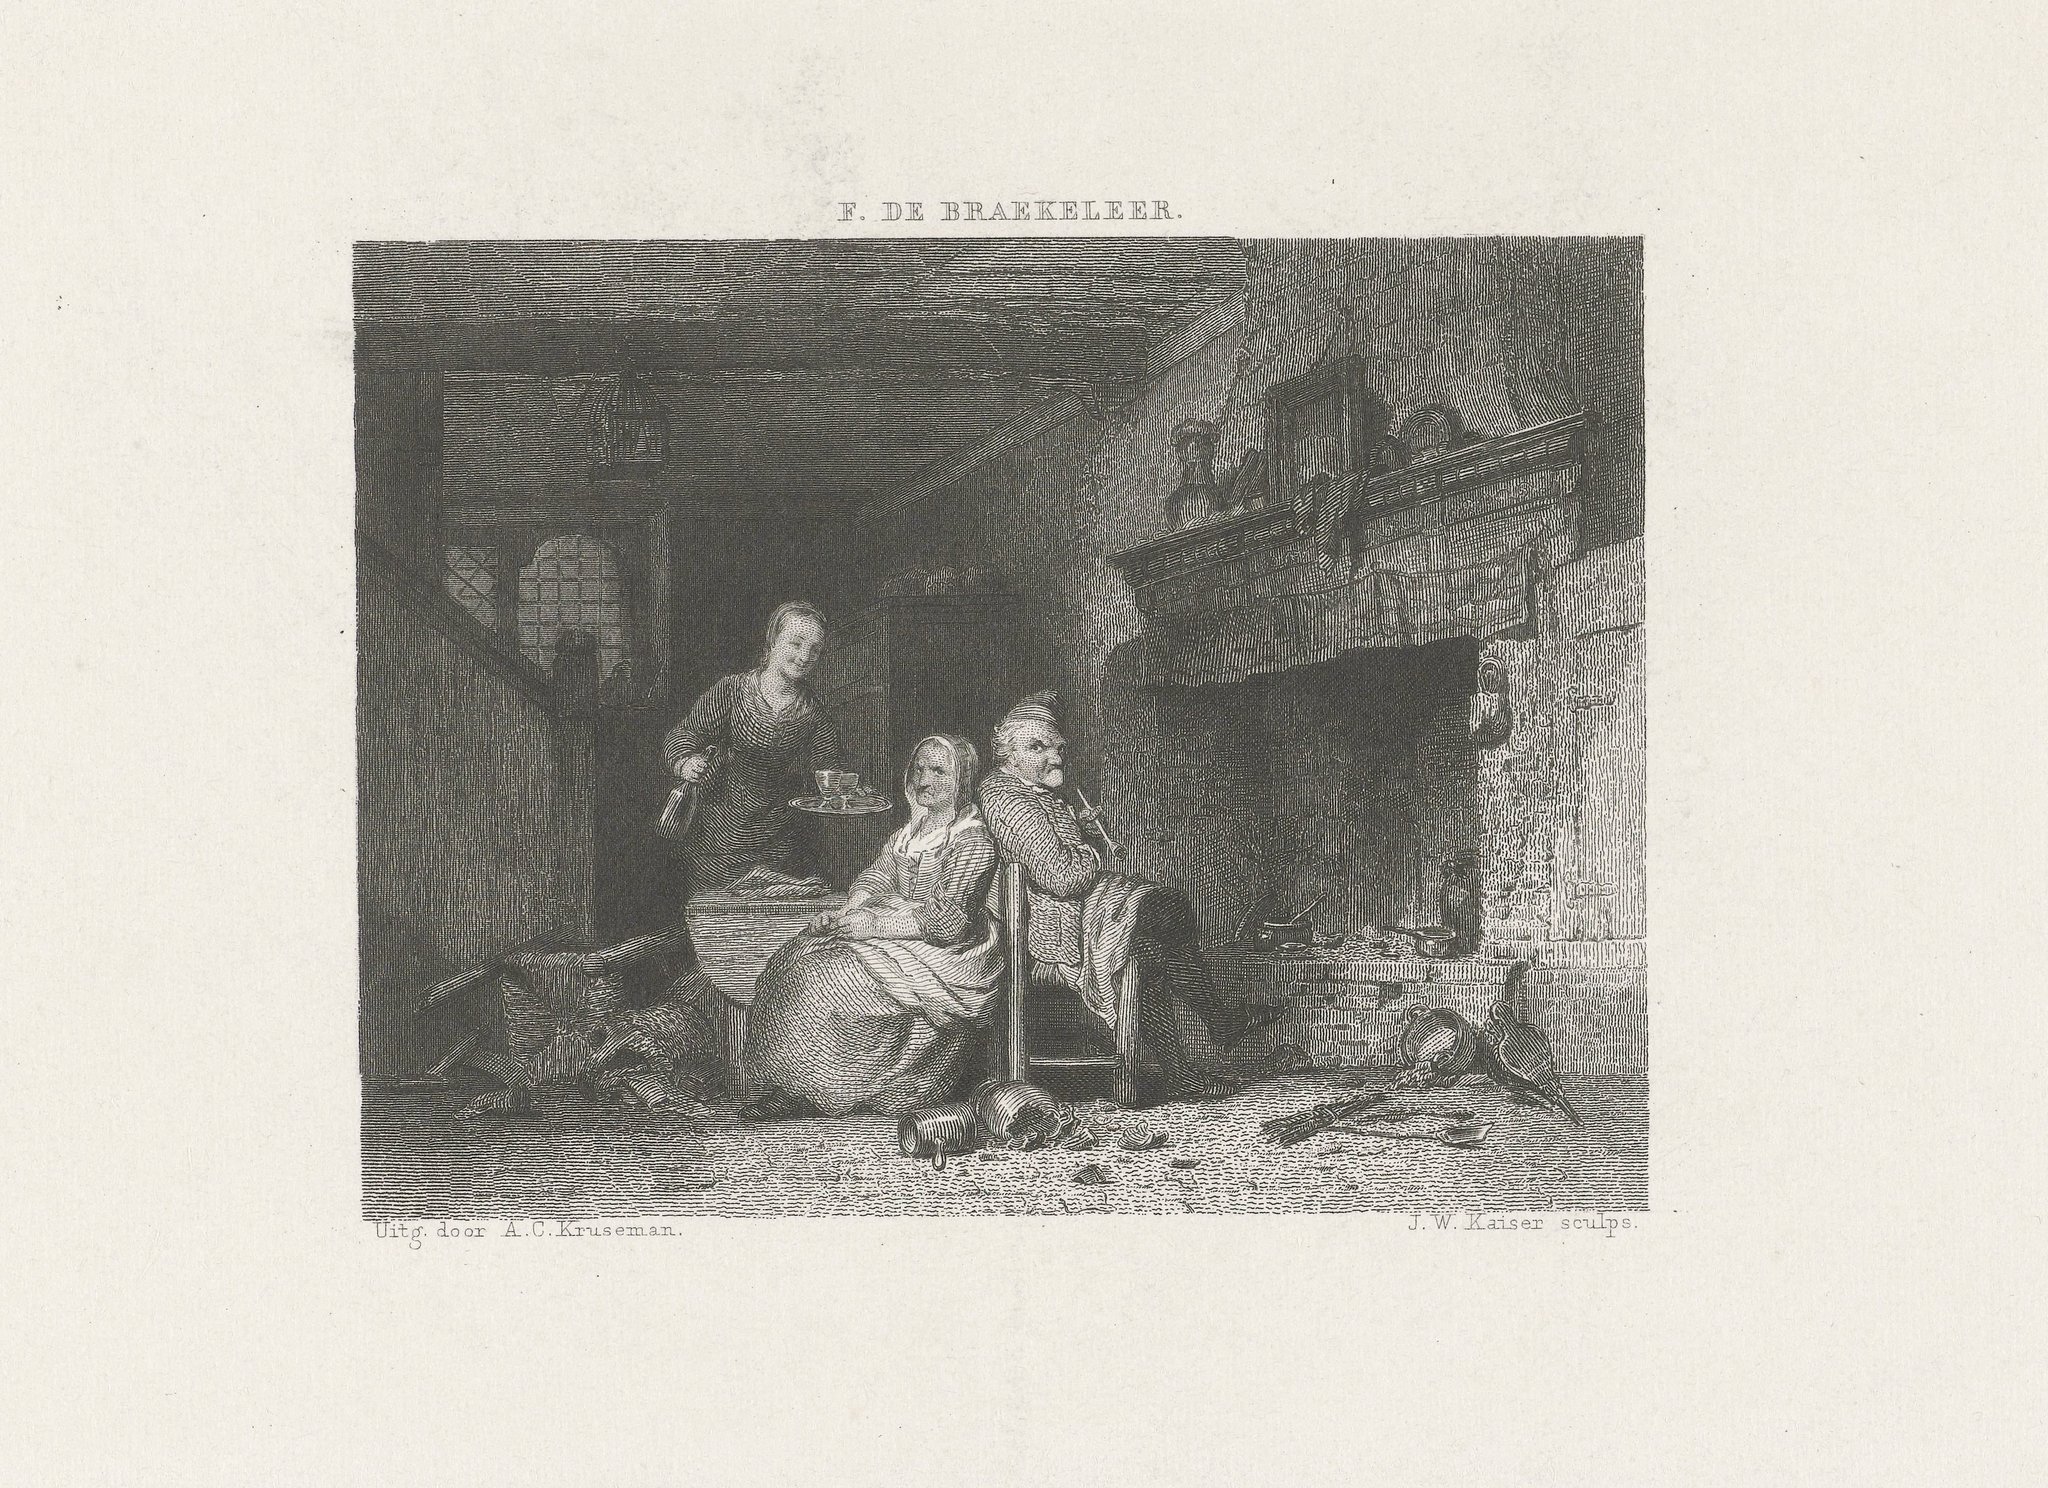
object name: print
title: Interieur met drie personen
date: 1856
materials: paper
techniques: etching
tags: interior of the house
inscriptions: inscription: ‘tekening van F de Braekeleer 1856 in de coll J.W. Kerklaan, uit aurora 1856’, collector's mark: Lugt 2228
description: In een vertrek zitten een norse oude man en een nukkige oude vrouw met hun ruggen naar elkaar toe. De man rookt een pijp voor de haard. Bij de tafel staat een dienstmeid met een fles en twee glazen op een dienblad. Op de achtergrond ligt een kapotte stoel en bij de tafel liggen de scherven van een gebroken kruik.